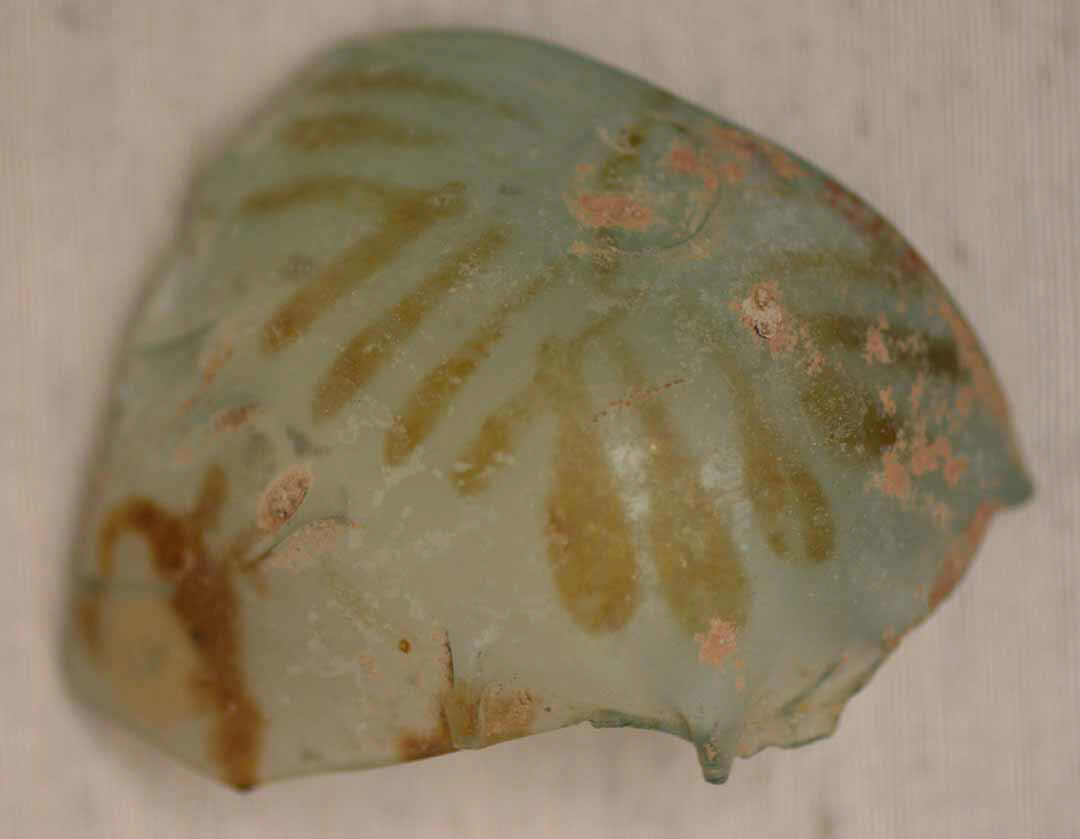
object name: fragment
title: Glass Fragment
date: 801-900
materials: glass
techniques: luster painting, stain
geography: egypt or iraq